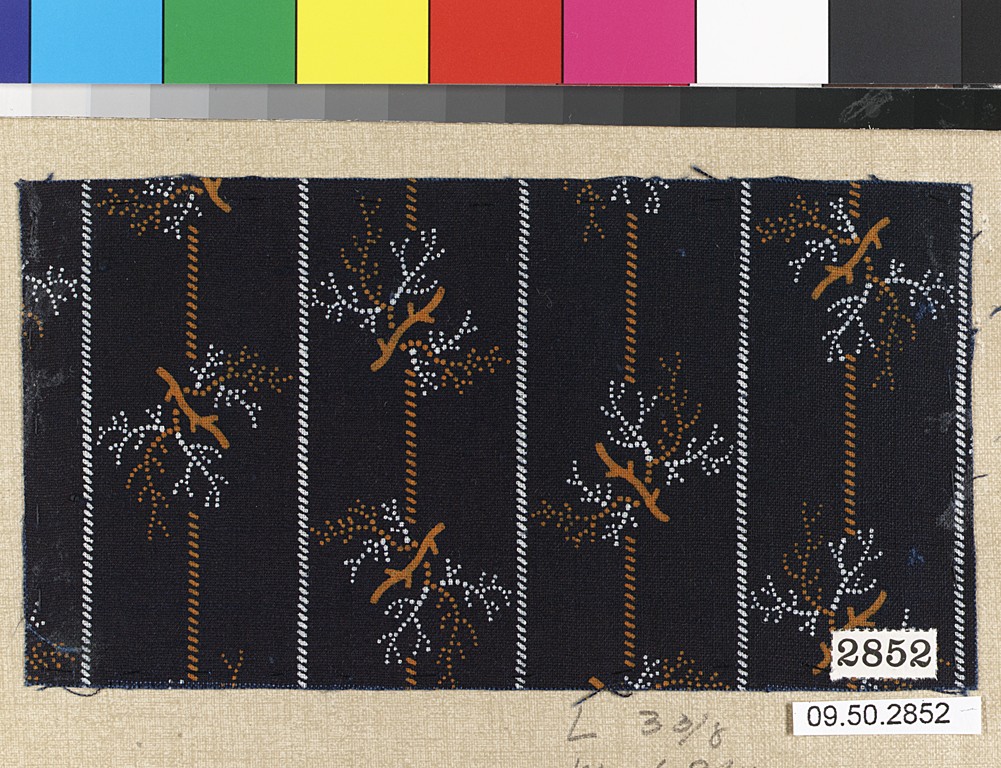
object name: piece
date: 1801-1900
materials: cotton